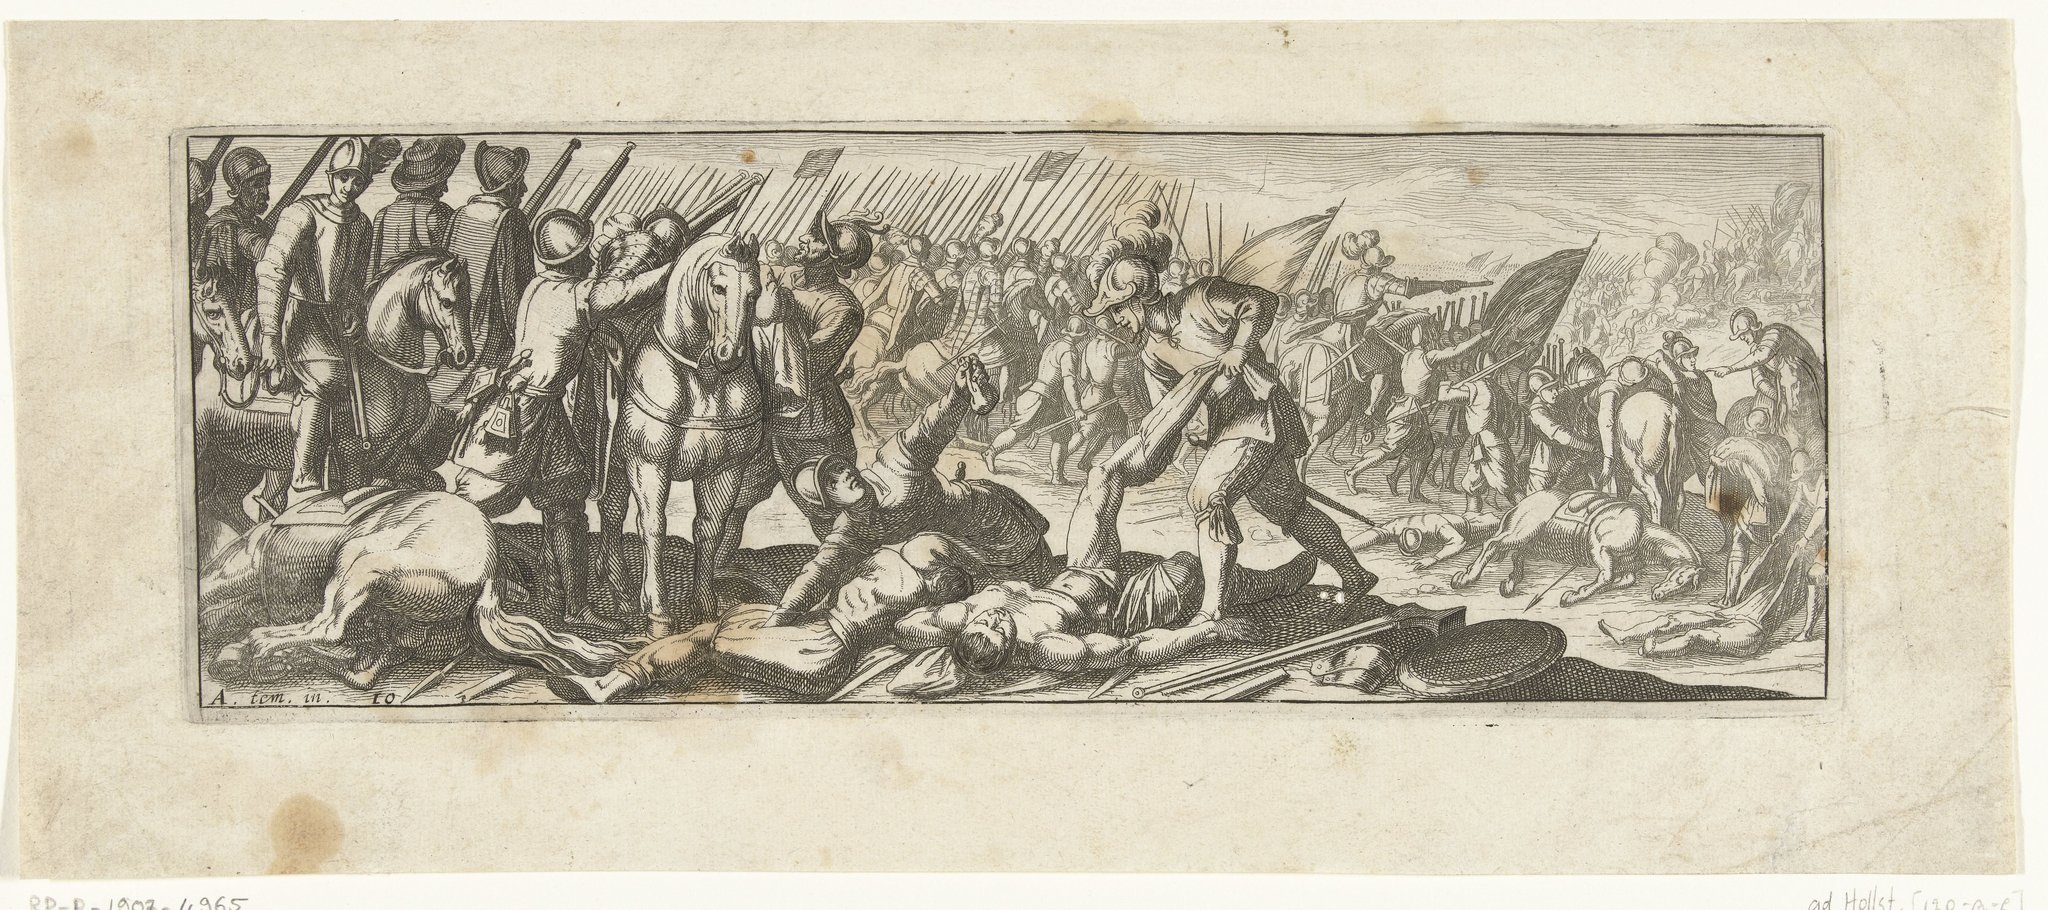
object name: print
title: Soldaten bestelen hun slachtoffers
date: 1591-1659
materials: paper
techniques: engraving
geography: amsterdam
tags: plundering ~ soldiers, warfare; military affairs (+ during the battle)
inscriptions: collector's mark: Lugt 2228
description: Gevechtsscène. Op de voorgrond soldaten die hun buit halen bij dode vijanden. Op de achtergrond is het gevecht nog aan de gang. Prent tien uit een serie met gevechtsscènes naar Antonio Tempesta.